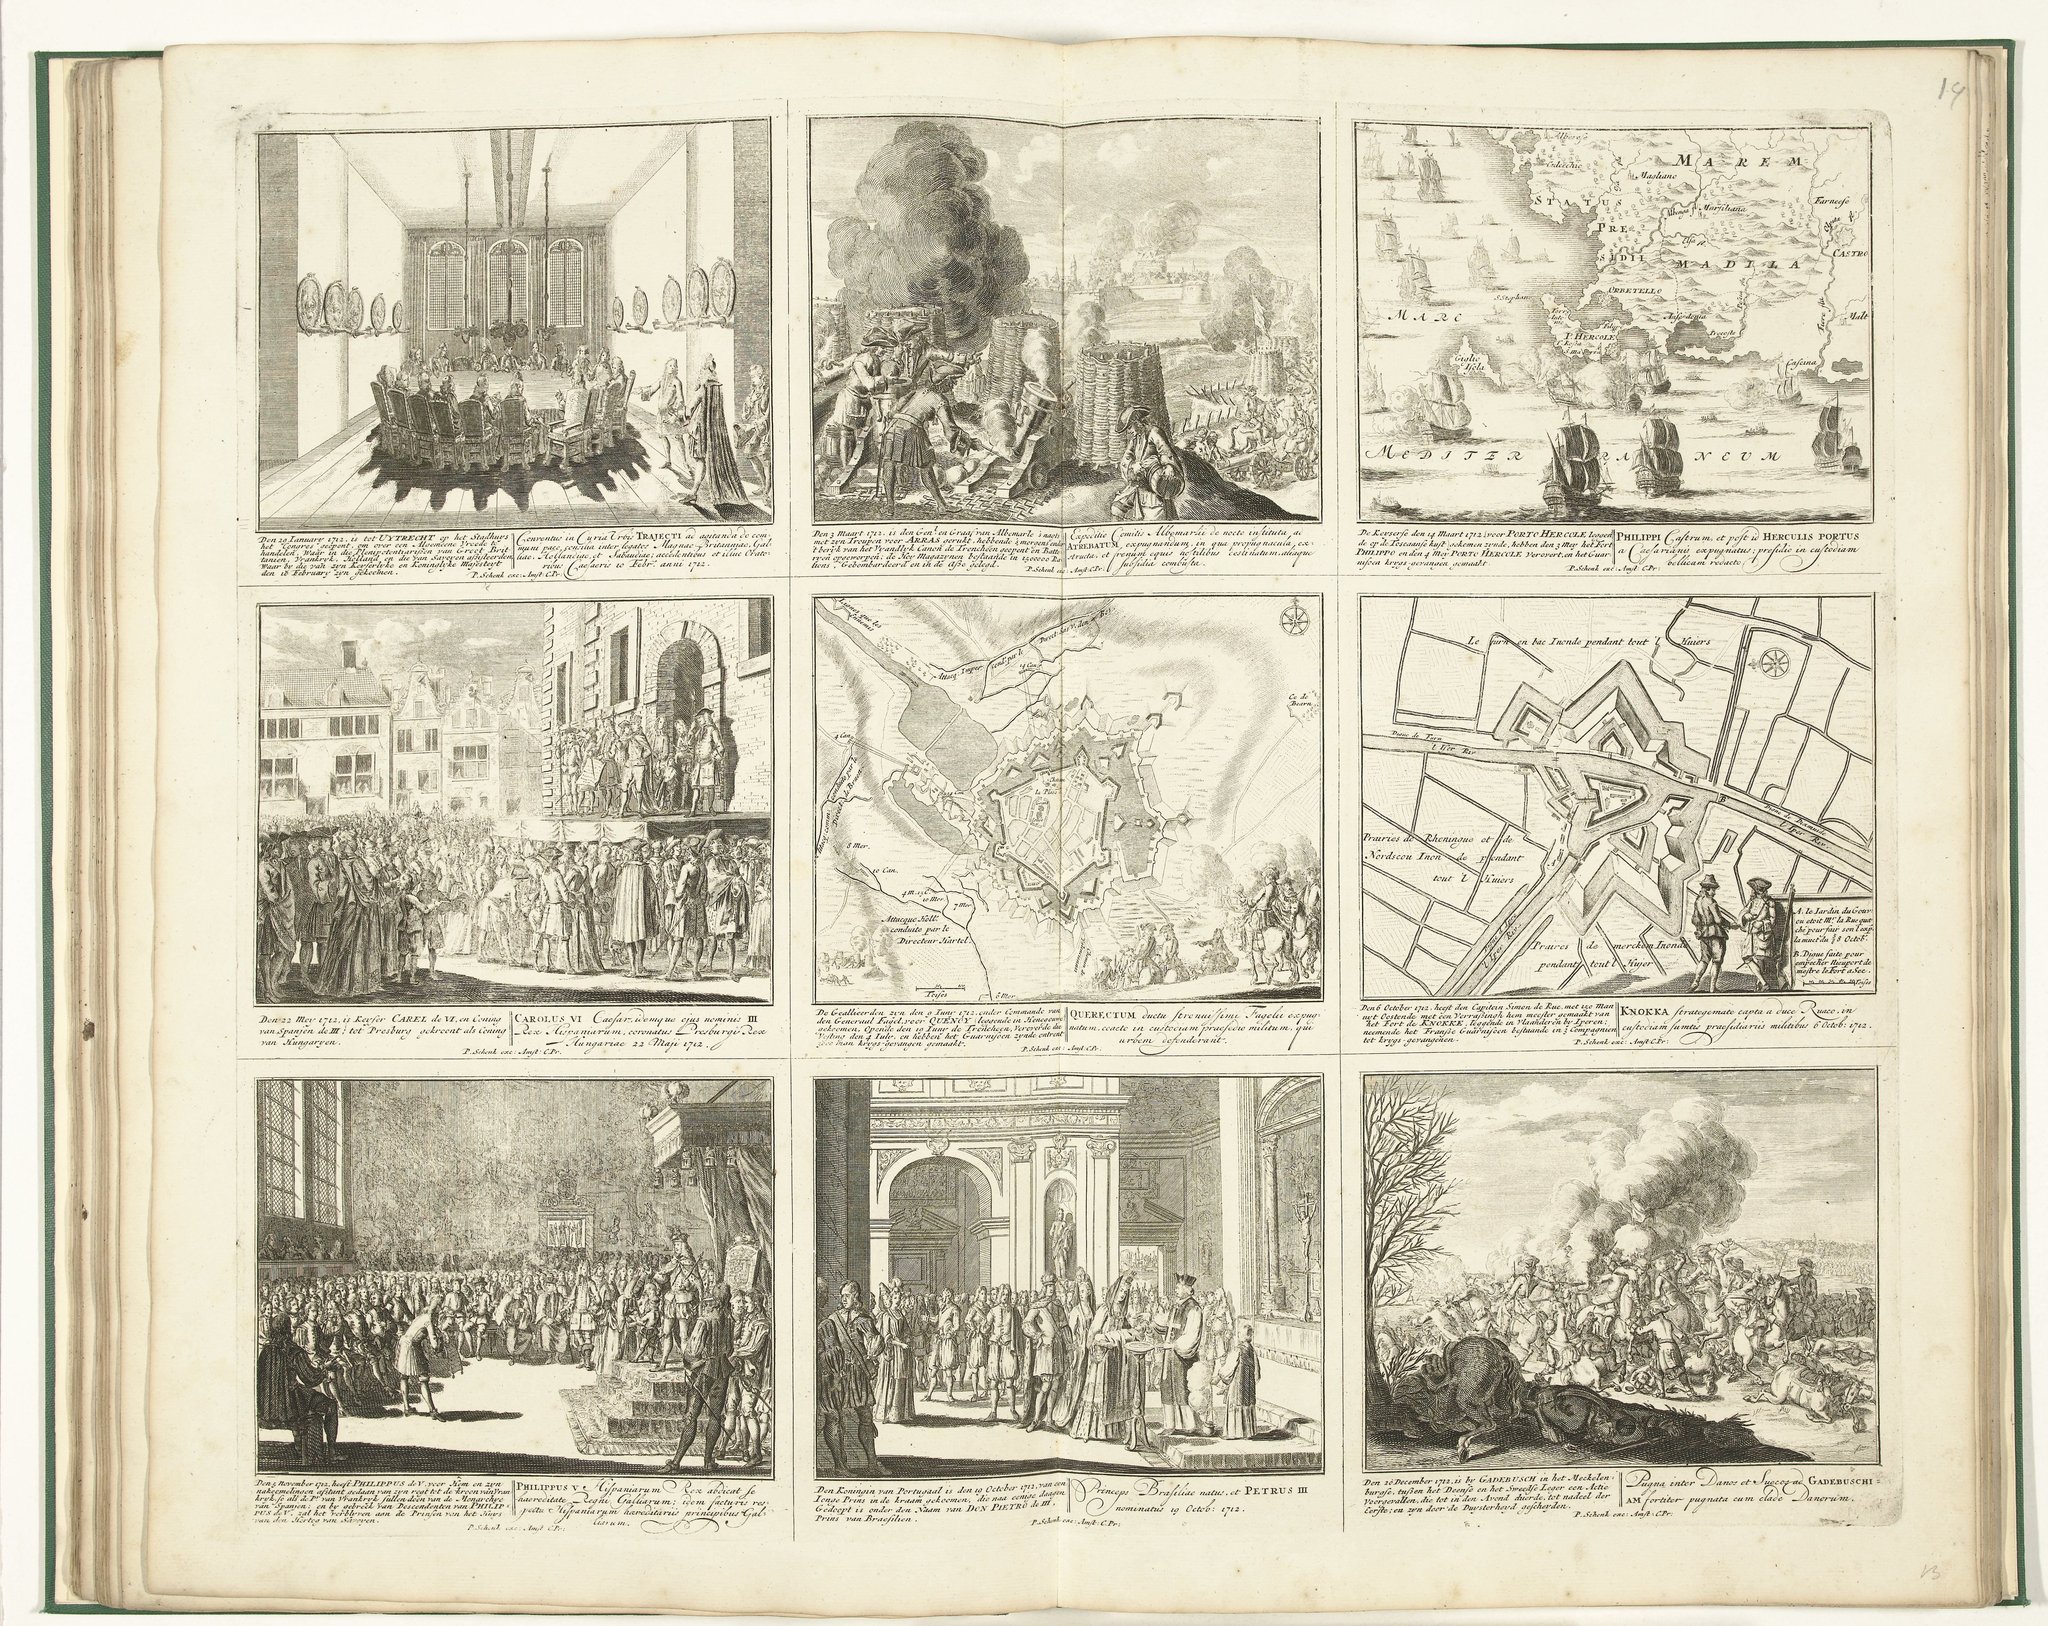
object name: print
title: Schouwburg van den Oorlog, Beginnende van Koning Karel den II. Tot op Koning Karel den III. Bestaande in IX. Historische Figuren op een Olifants Blad, als Veldslagen, Belegeringen te Water en te Lande, met de voornaamste Vestingen (...)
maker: pieter schenk (i)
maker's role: print maker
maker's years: 1660-1711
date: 1712-1720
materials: paper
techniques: etching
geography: amsterdam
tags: filips v (koning van spanje), vienna, charles vi (holy roman emperor), fortress, maps of separate countries or regions, maps of cities, battle (+ land forces)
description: Blad met negen voorstellingen van gebeurtenissen uit het jaar 1712 van de Spaanse Successieoorlog en van plattegronden van versterkte steden. Blad XIII in: Schouwburg van den oorlog (editie van 1720), het prentwerk met de gebundelde reeks van 31 platen over de Spaanse Successieoorlog.